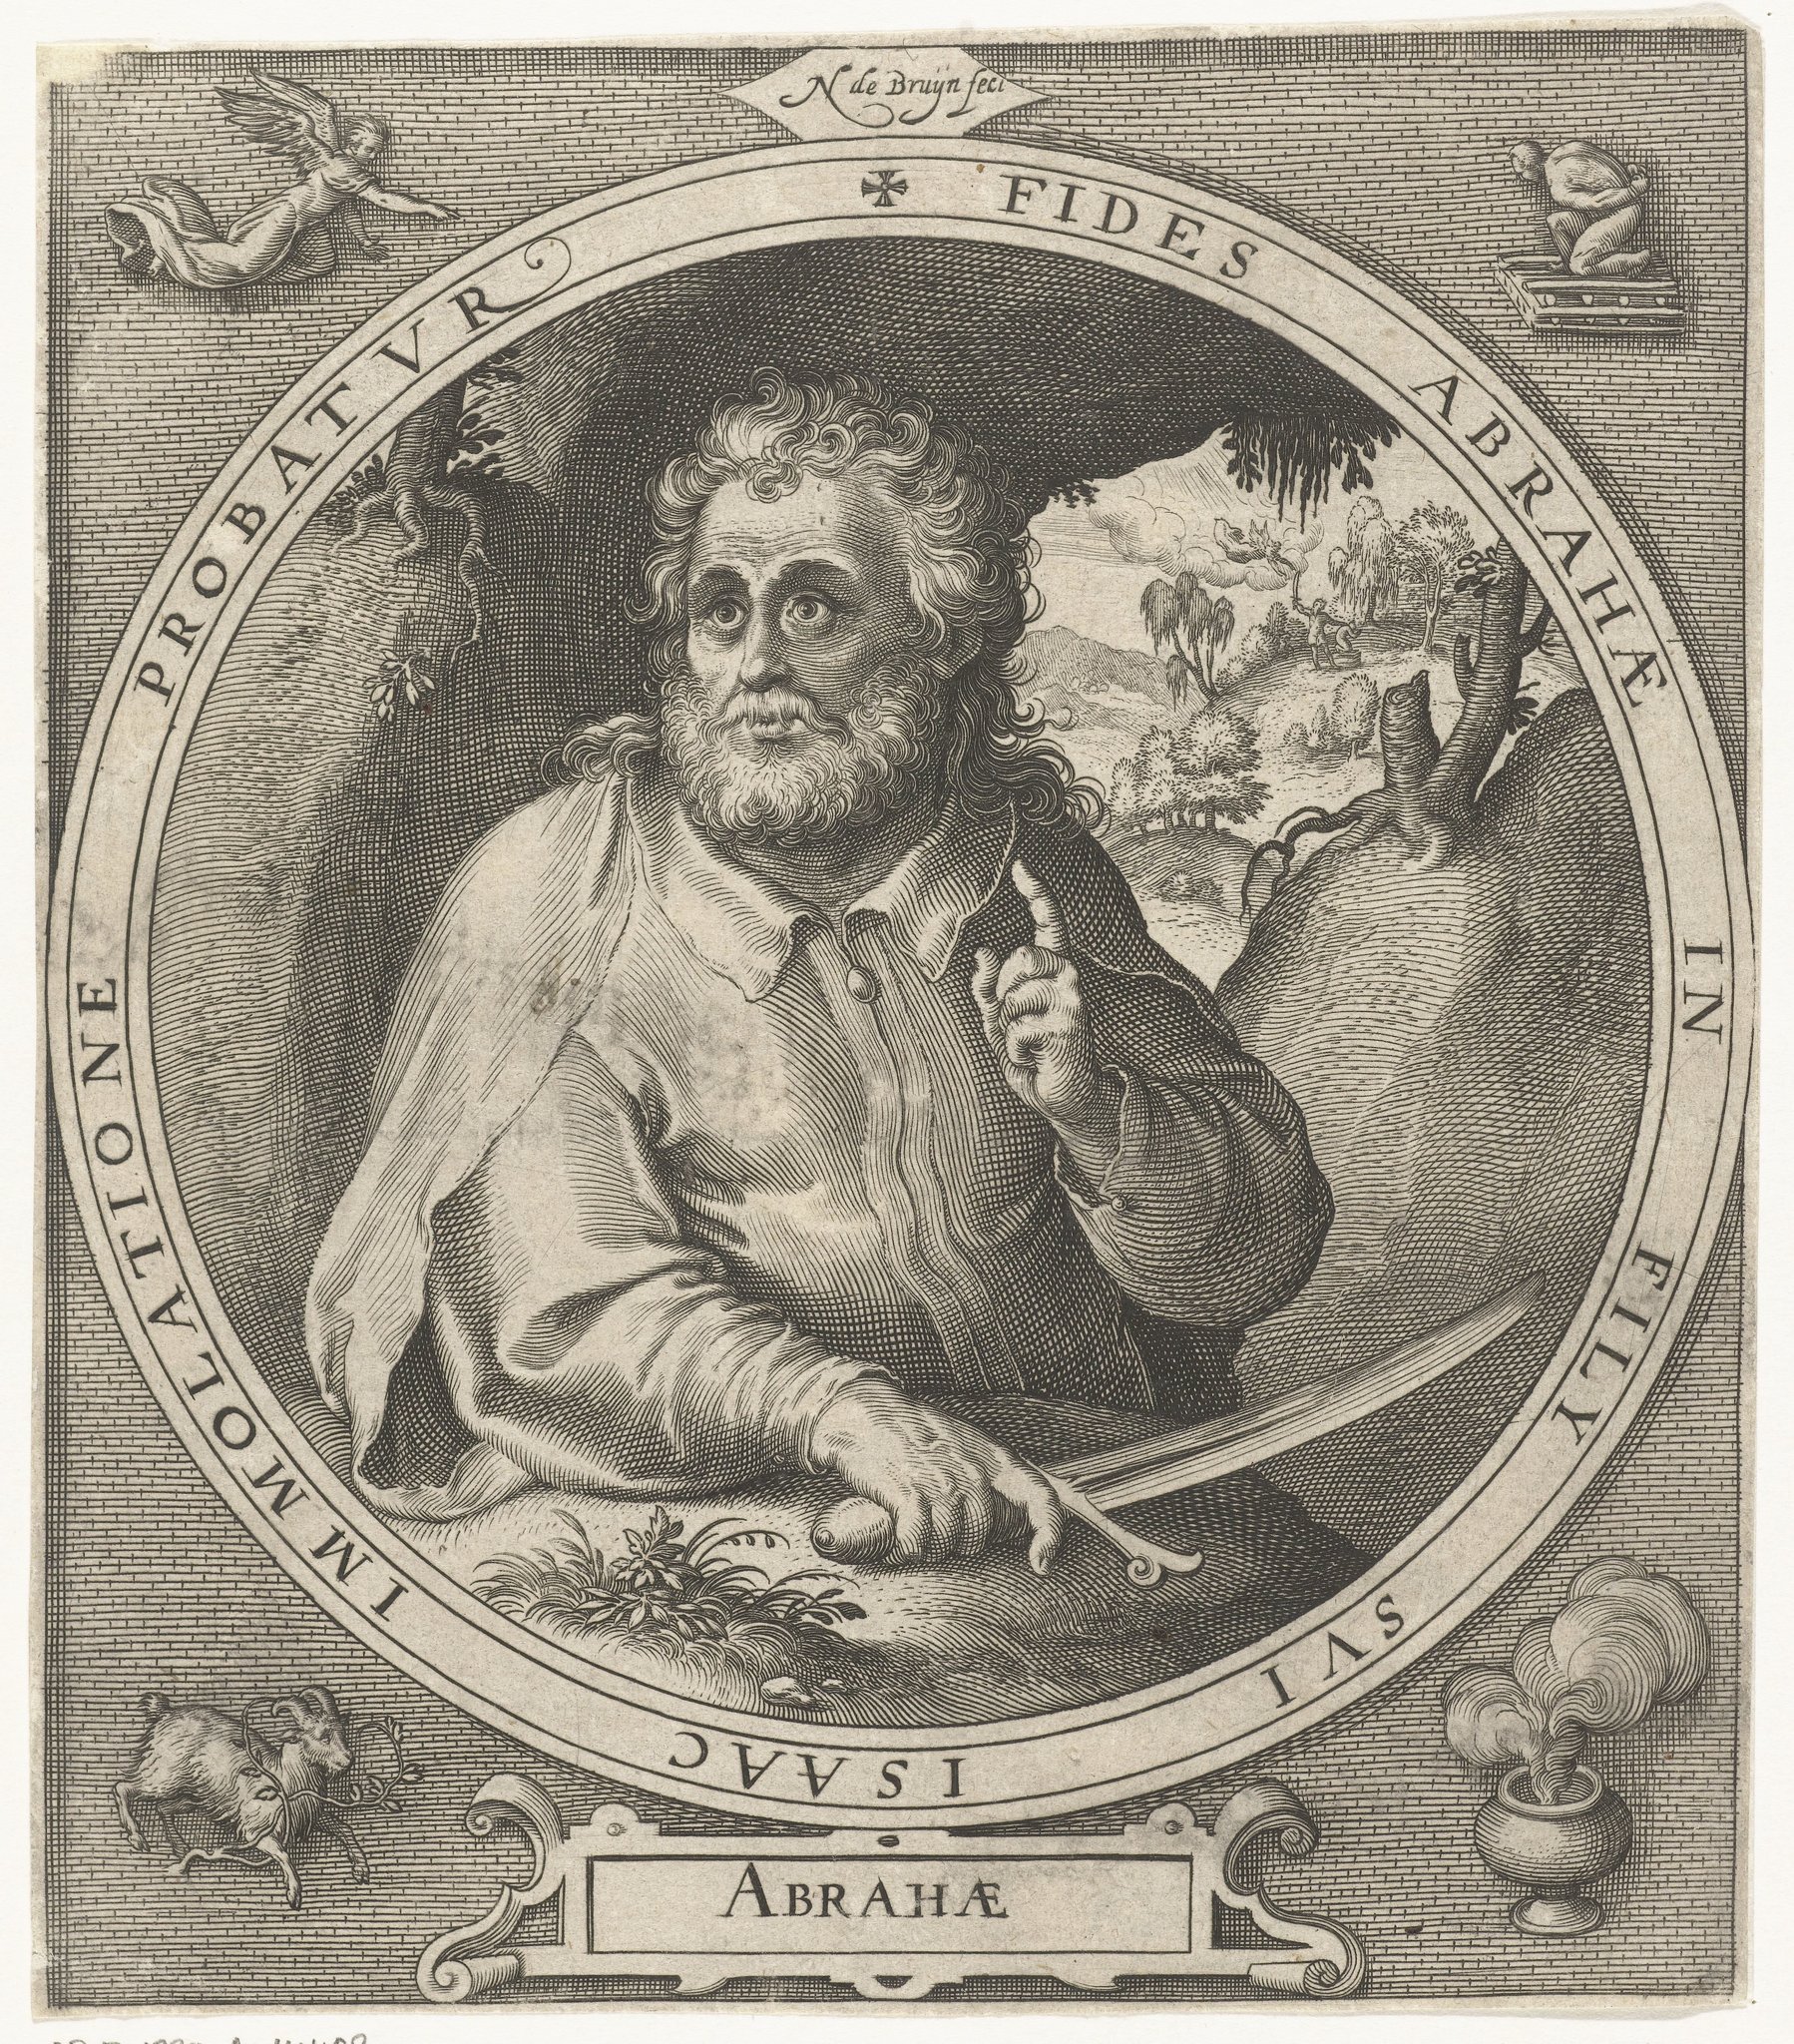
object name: print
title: Abrahae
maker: nicolaes de bruyn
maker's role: print maker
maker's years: 1571-1656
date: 1581-1656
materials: paper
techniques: engraving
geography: netherlands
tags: when abraham has his hand raised to kill isaac, god or the hand of god restrains abraham's hand, abraham (not in biblical context); possible attribute: knife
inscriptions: collector's mark: Lugt 2228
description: Abraham met mes zittend in landschap met in de verte een scène uit het bijbelverhaal waarin de engel Abraham weerhoudt van het offeren van zijn zoon Isaak. In ronde omlijsting met opschrift in Latijn en in hoeken van rechthoekig kader voorwerpen en figuren die verwijzen naar het bijbelverhaal zoals de engel en de ram die in plaats van Isaak geofferd zal worden.